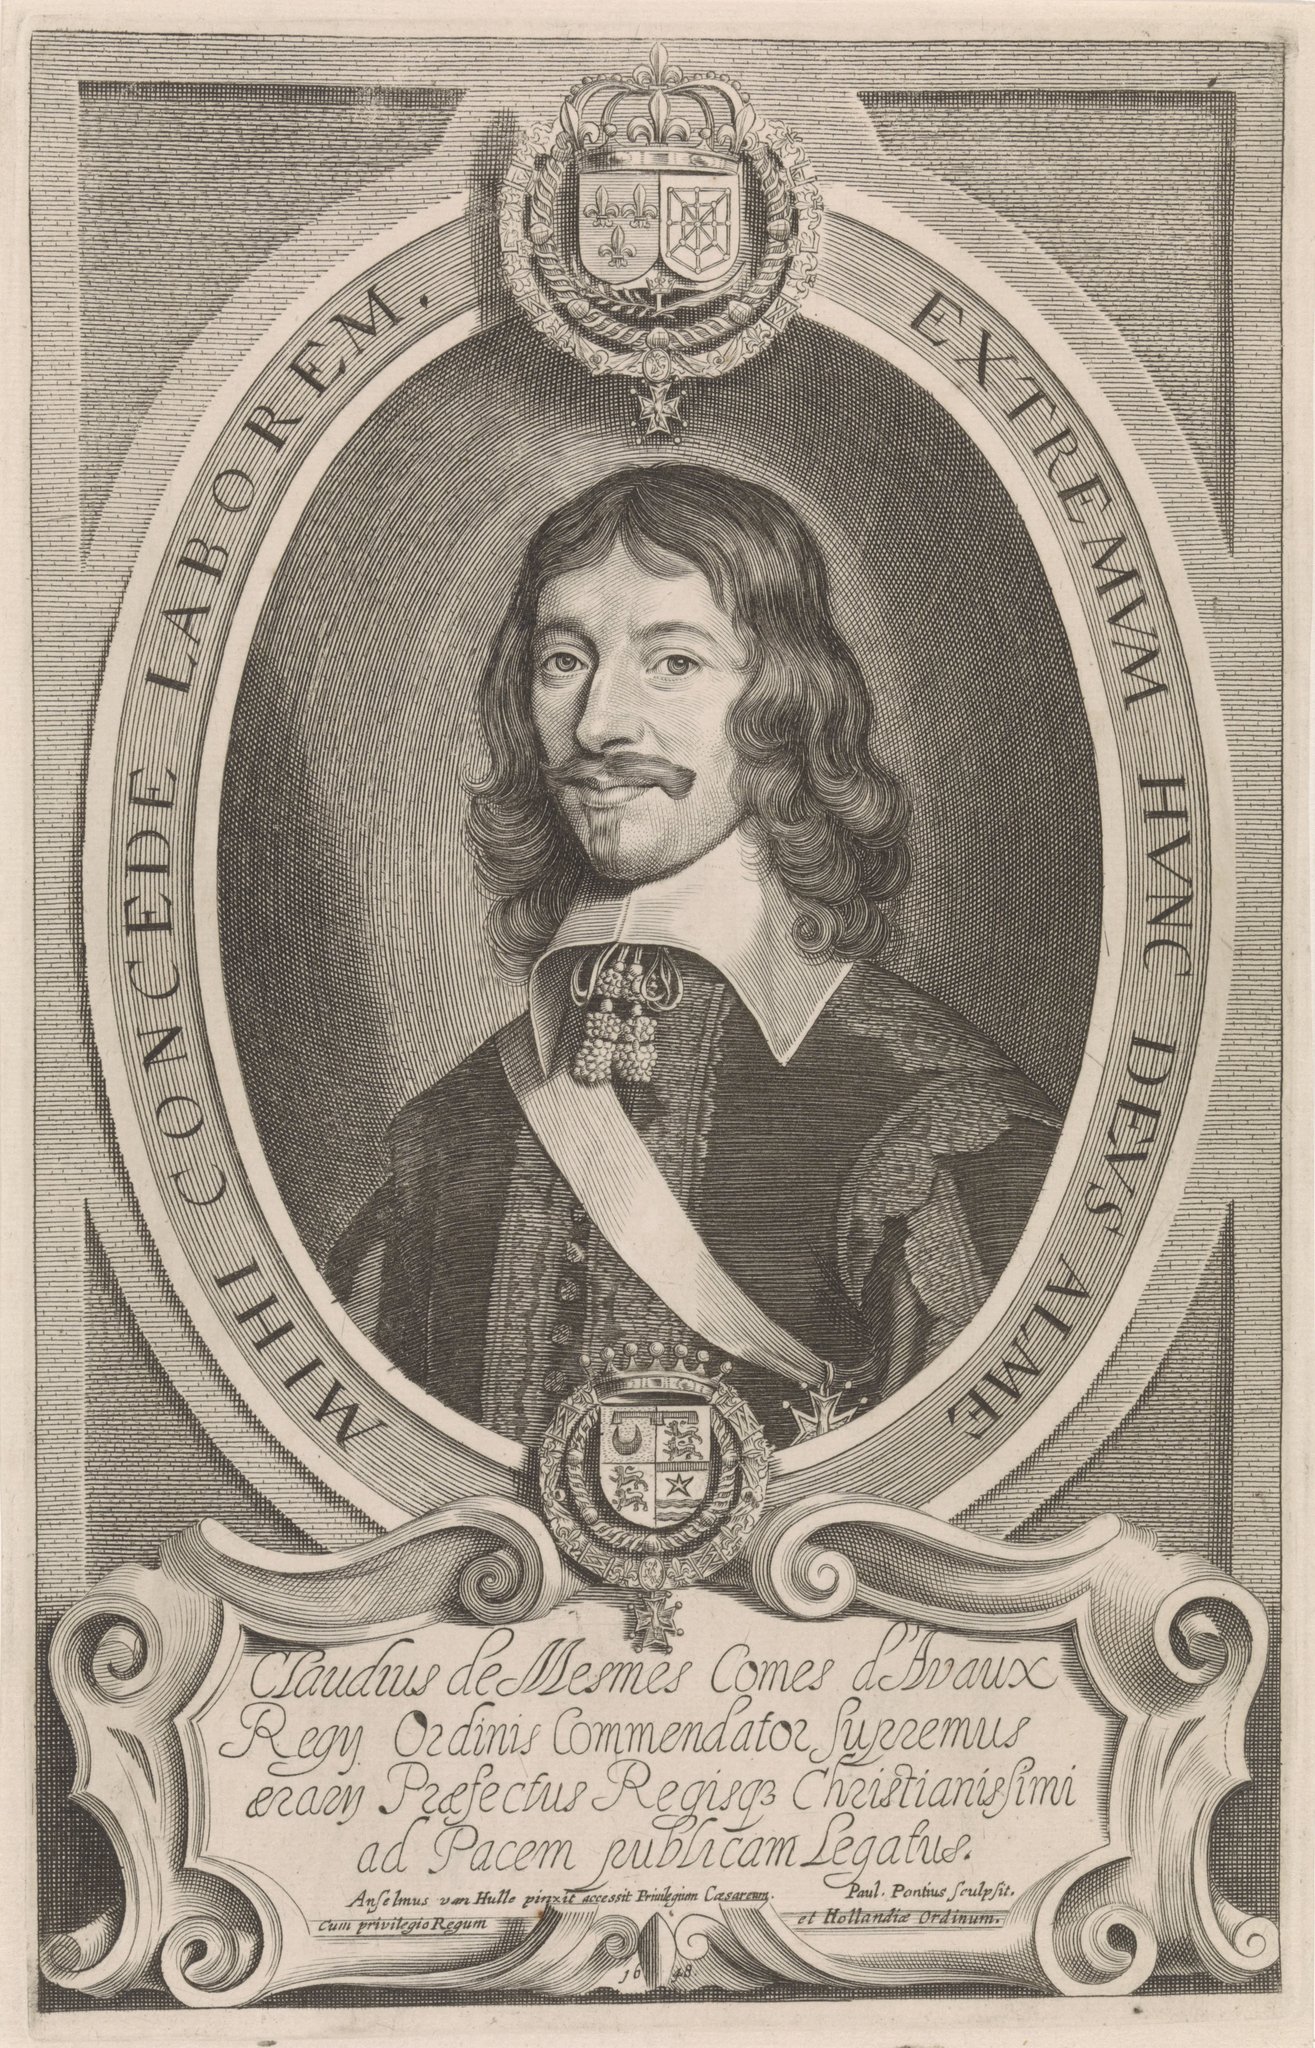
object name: print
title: Portret van Claudius de Mesmes, graaf d'Avaux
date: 1648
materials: paper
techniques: engraving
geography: antwerp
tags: knighthood order of the holy spirit, armorial bearing, heraldry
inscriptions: collector's mark: Lugt 2228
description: Prent ook opgenomen in: Pacificatores orbis christiani, sive Icones principum, ducum et legatorum, qui Monasterii atque Osnabrugæ pacem Europæ reconciliarunt (...). = Pronkbeelden der vorsten, en vredehandelaars. Rotterdam: Pieter van der Slaart, 1697.